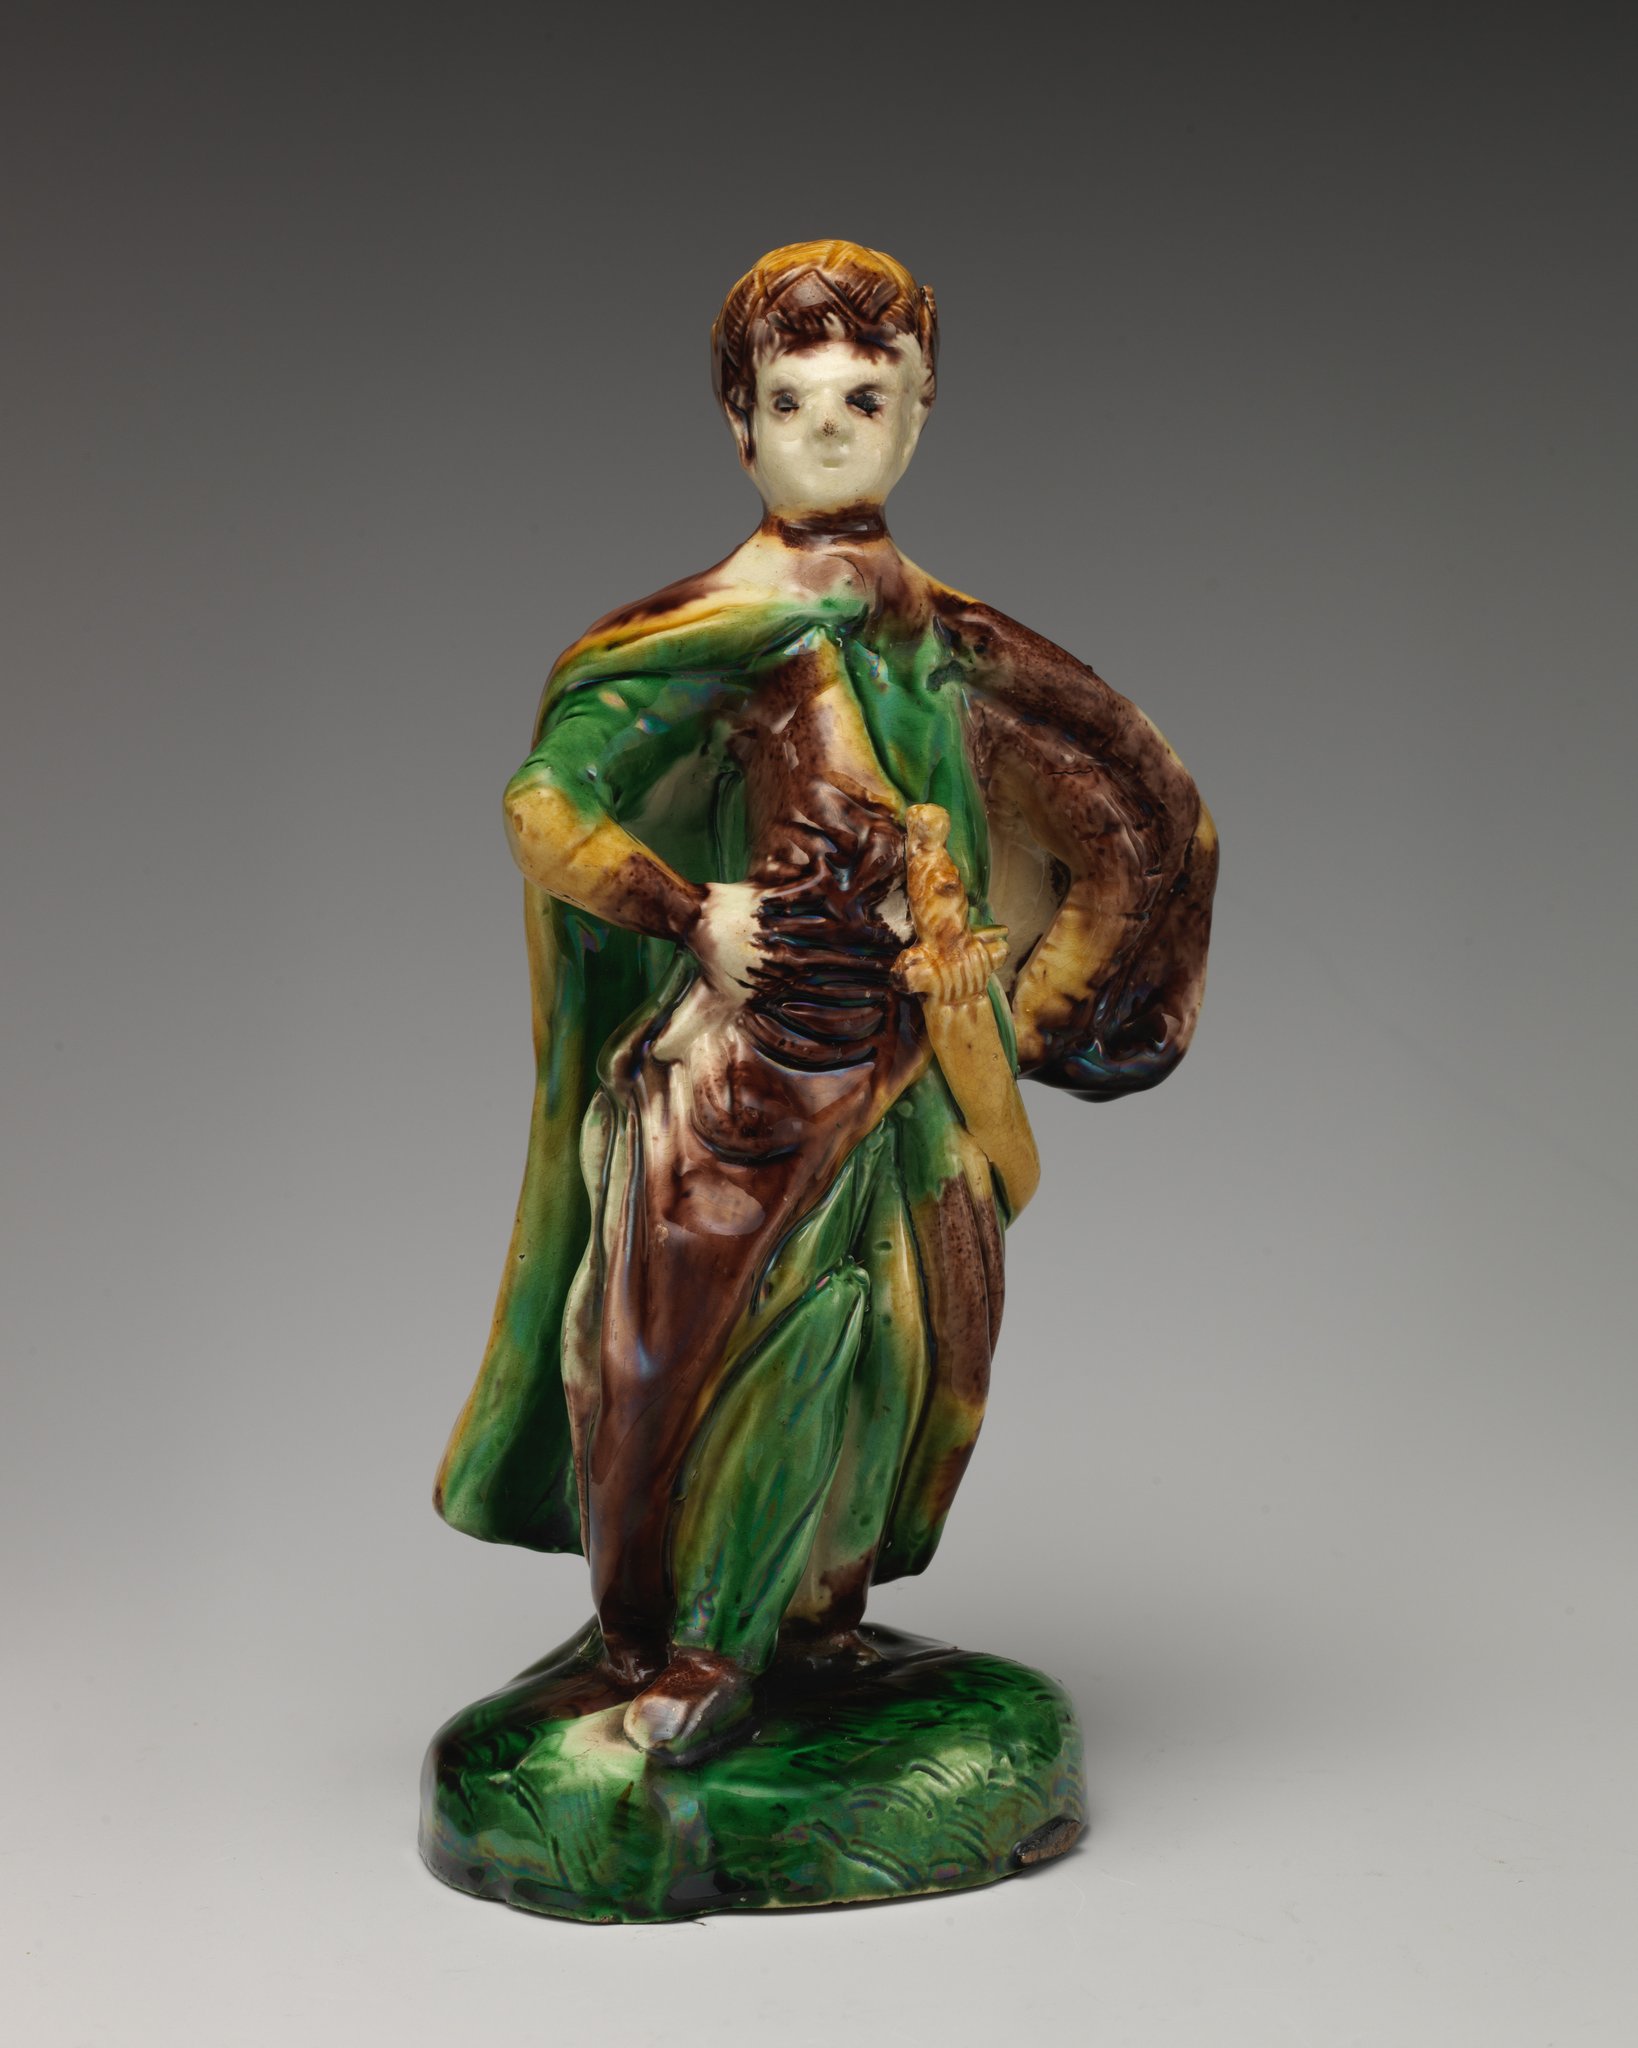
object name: figure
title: Turk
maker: ralph wood the elder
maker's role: maker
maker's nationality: british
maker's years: 1715-1772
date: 1760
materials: earthenware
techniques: glazing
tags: men